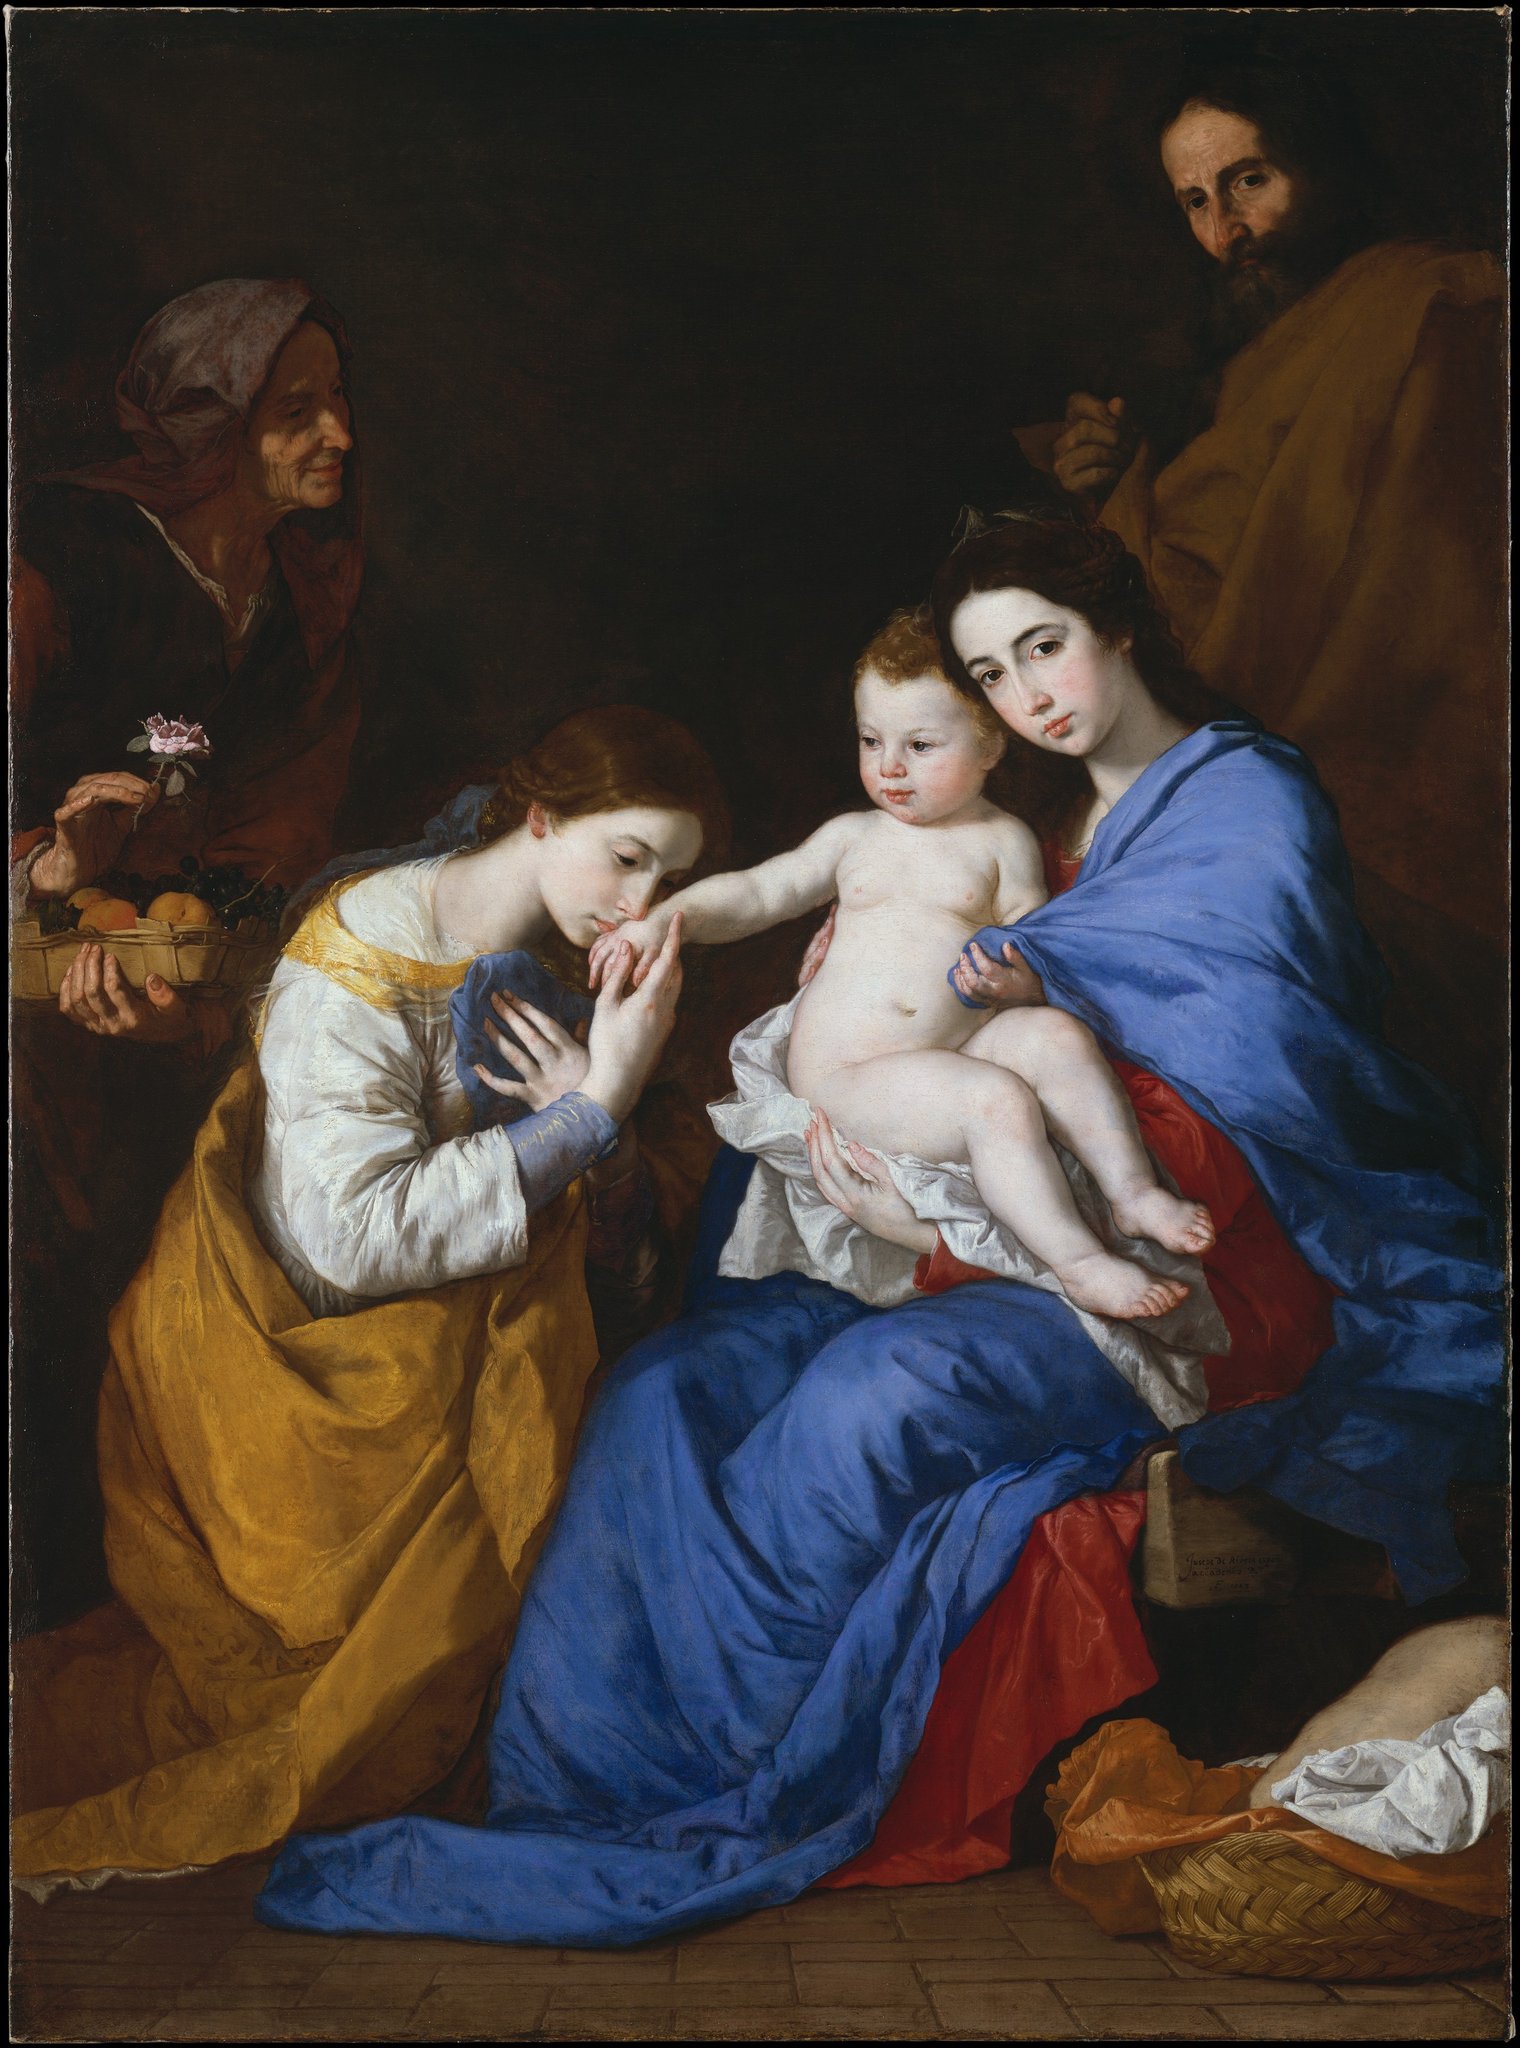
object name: painting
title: The Holy Family with Saints Anne and Catherine of Alexandria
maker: jusepe de ribera (called lo spagnoletto)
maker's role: artist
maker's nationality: spanish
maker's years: 1591-1652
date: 1648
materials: canvas, oil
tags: holy family,saint anne,saint catherine,saint joseph,virgin mary,jesus